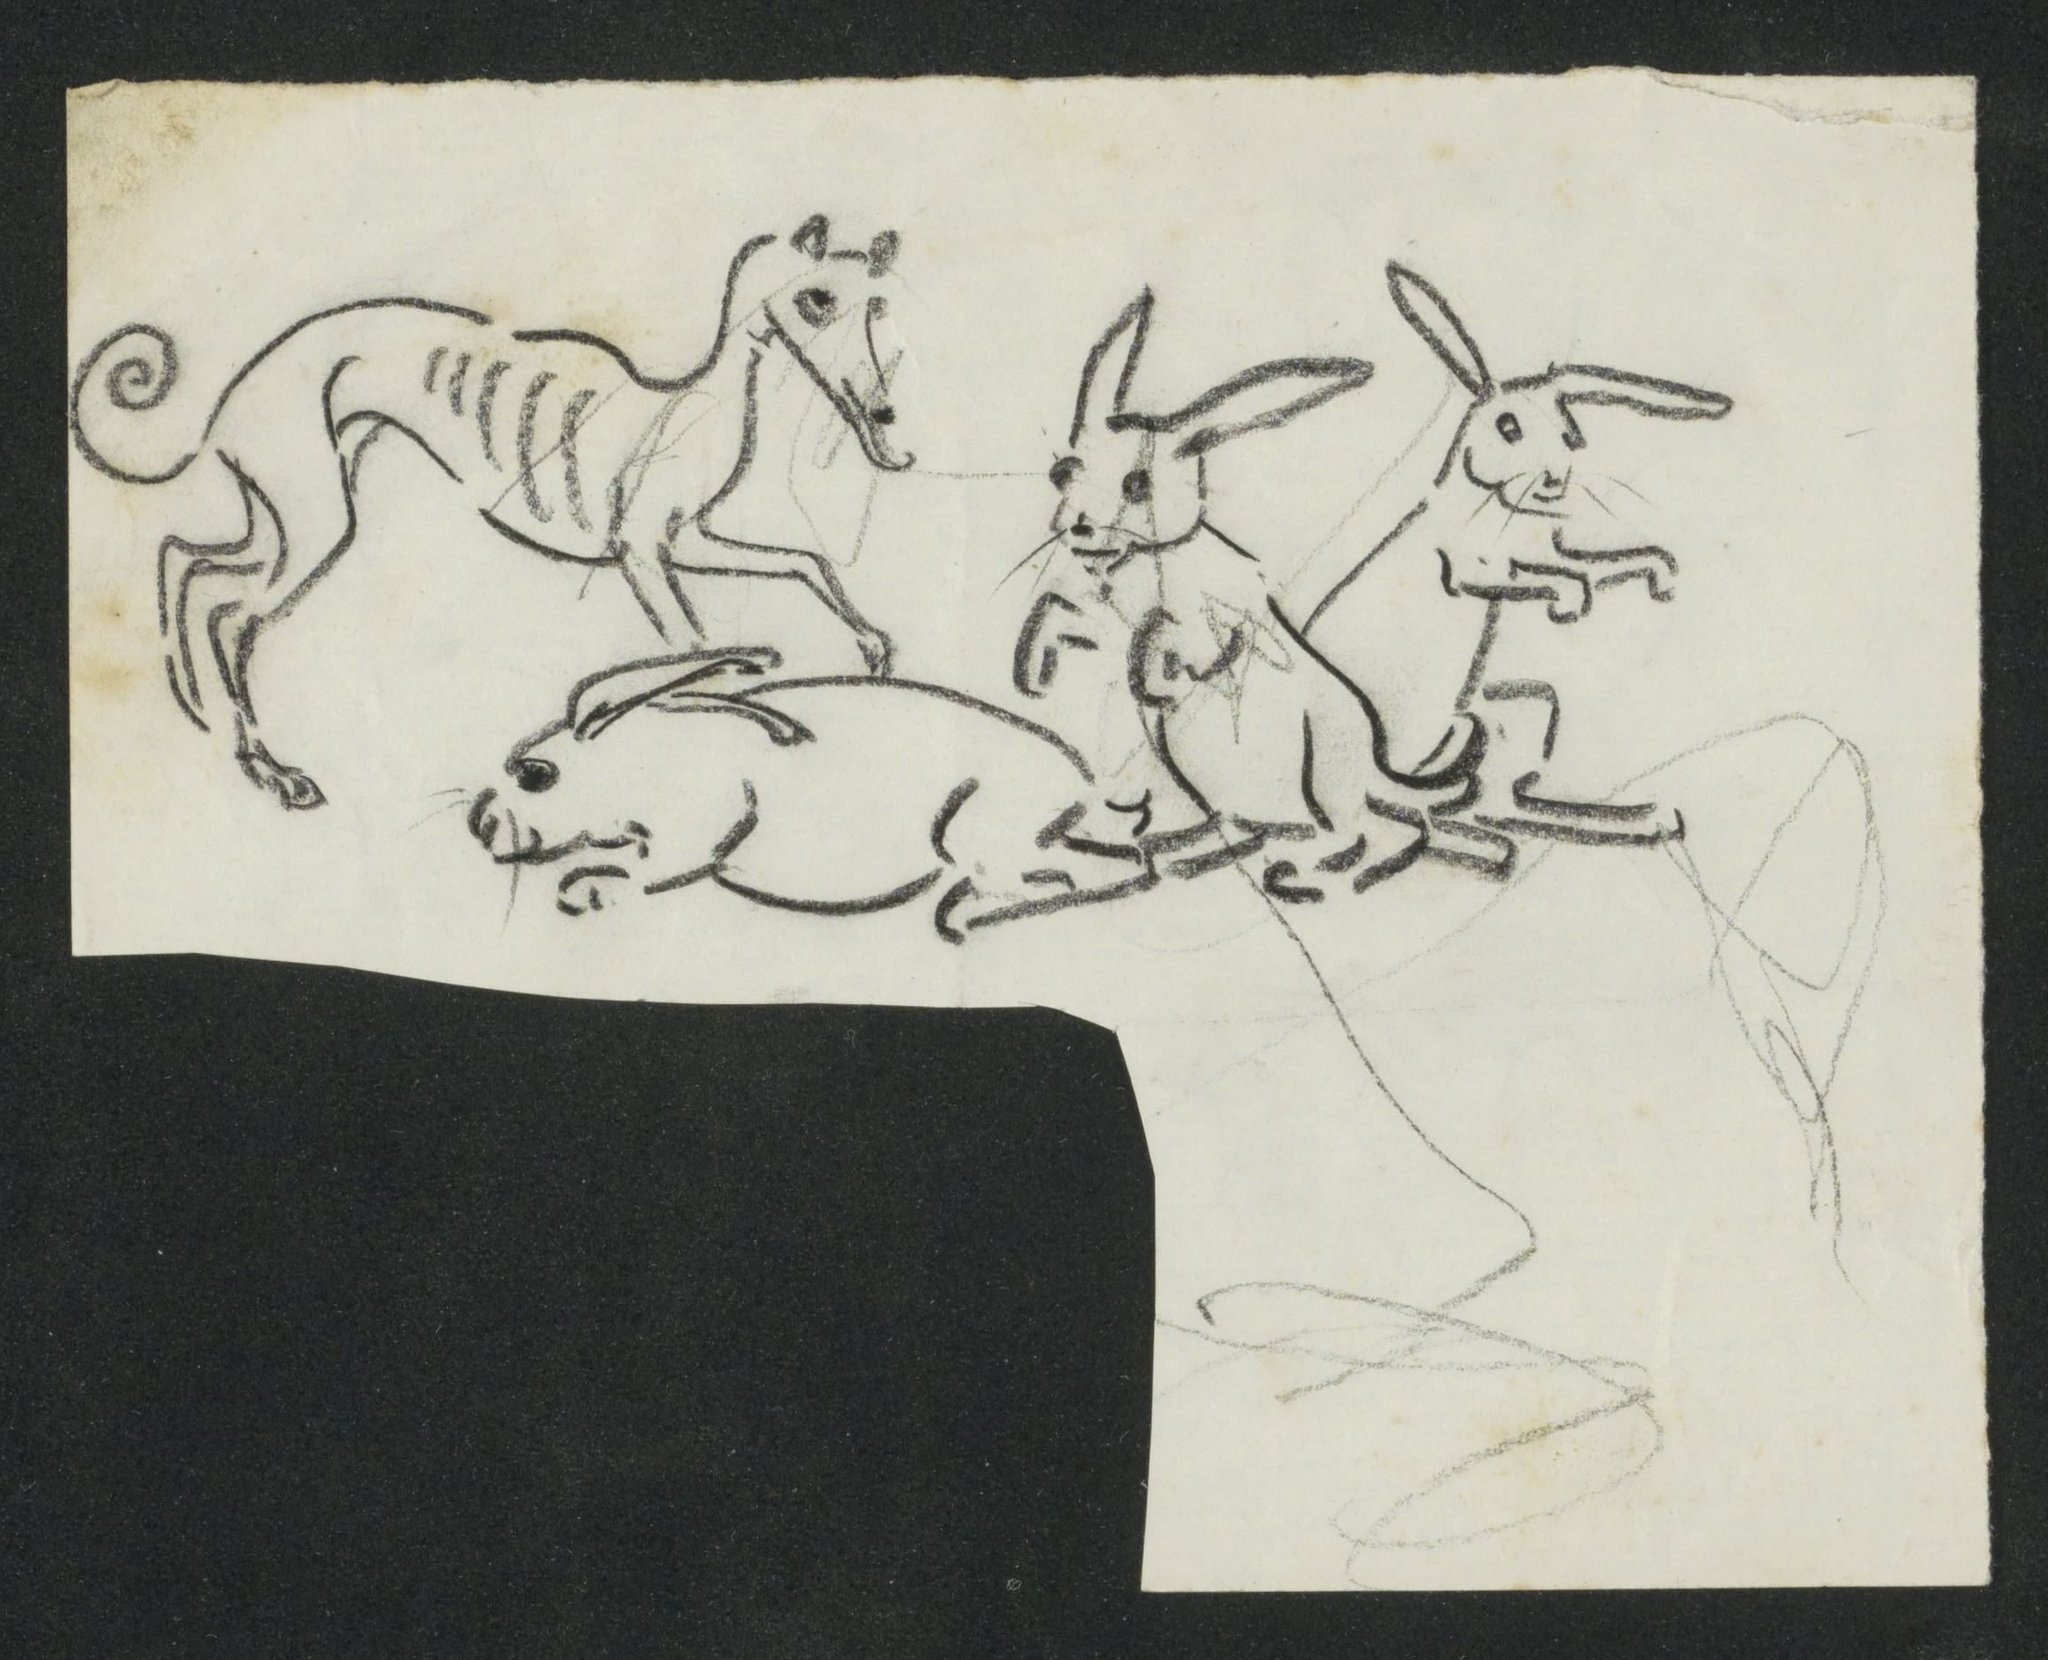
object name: drawing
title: Drie konijnen en een jachthond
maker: gerrit willem dijsselhof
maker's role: designer, draughtsman, print maker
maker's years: 1866-1924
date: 1876-1924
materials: chalk, paper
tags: rodents: rabbit